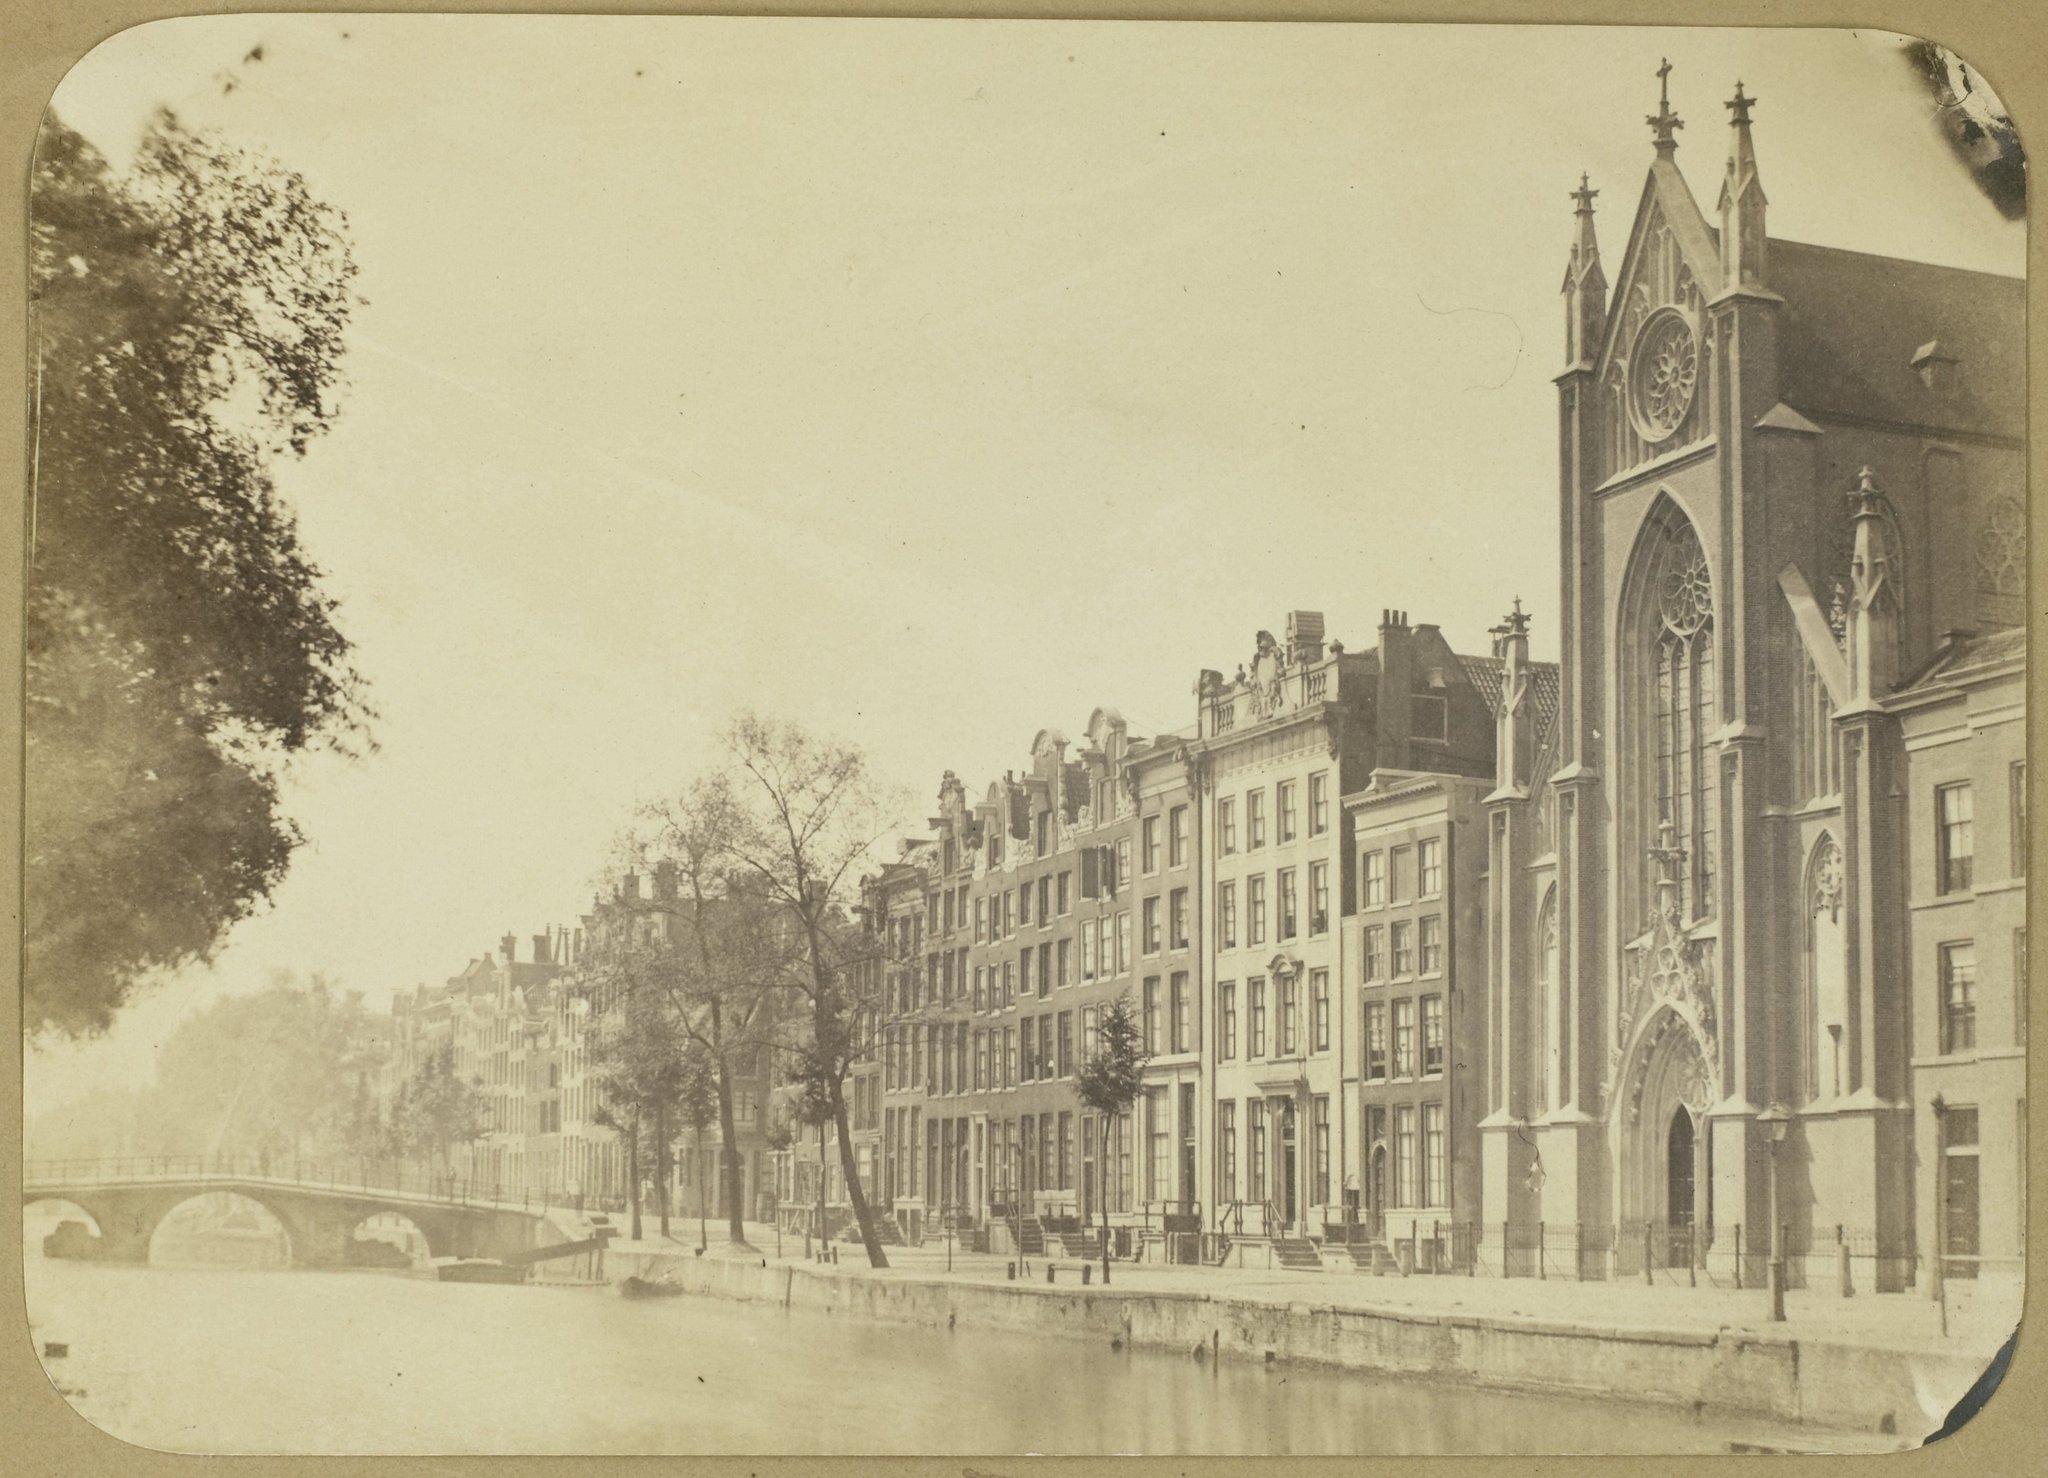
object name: photograph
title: Gezicht op de Keizersgracht in Amsterdam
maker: eduard isaac asser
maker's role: amateurfotograaf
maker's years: 1809-1894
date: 1855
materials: cardboard, paper, photographic support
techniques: salted paper print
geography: amsterdam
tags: keizersgracht, onze-lieve-vrouwekerk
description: tussen de Raadhuisstraat en de Reestraat, met rechts de Onze Lieve Vrouwekerk